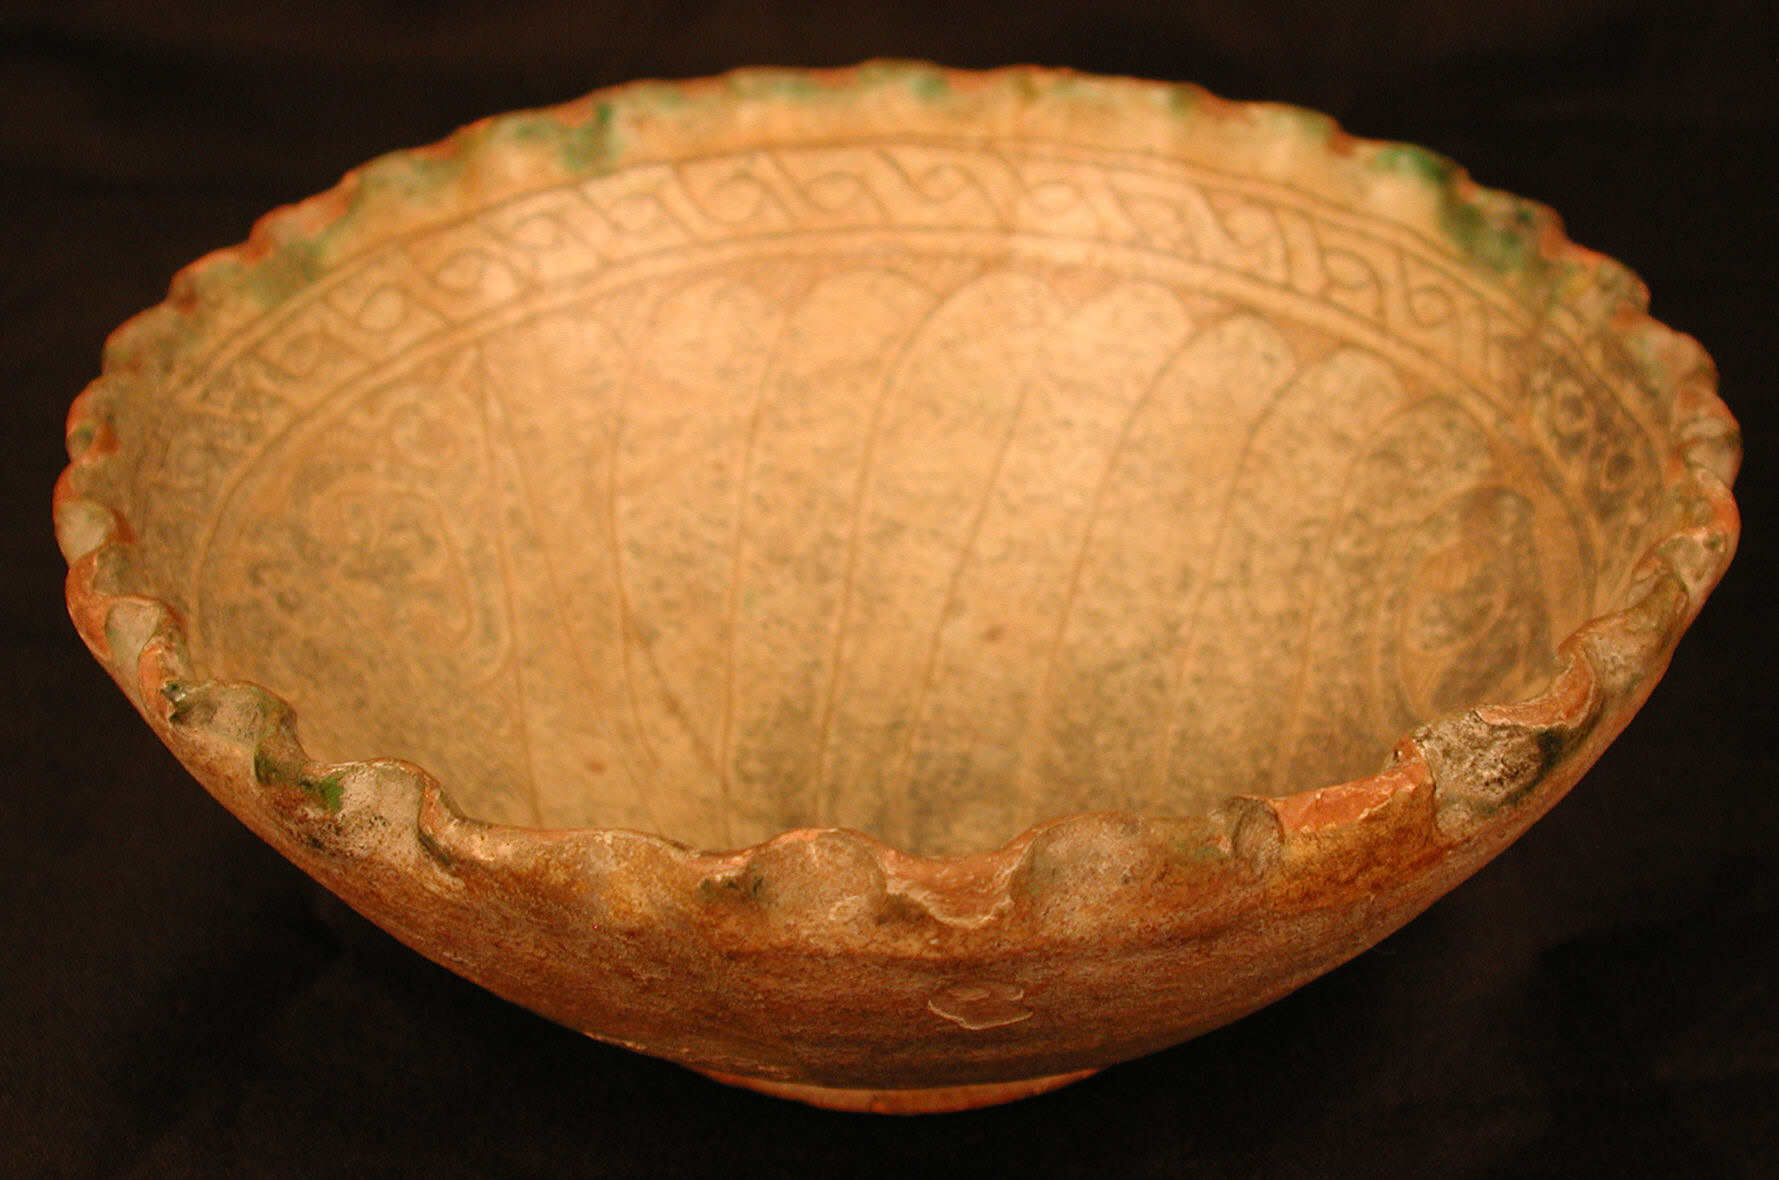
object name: bowl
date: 1101-1200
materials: earthenware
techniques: glazing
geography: iran